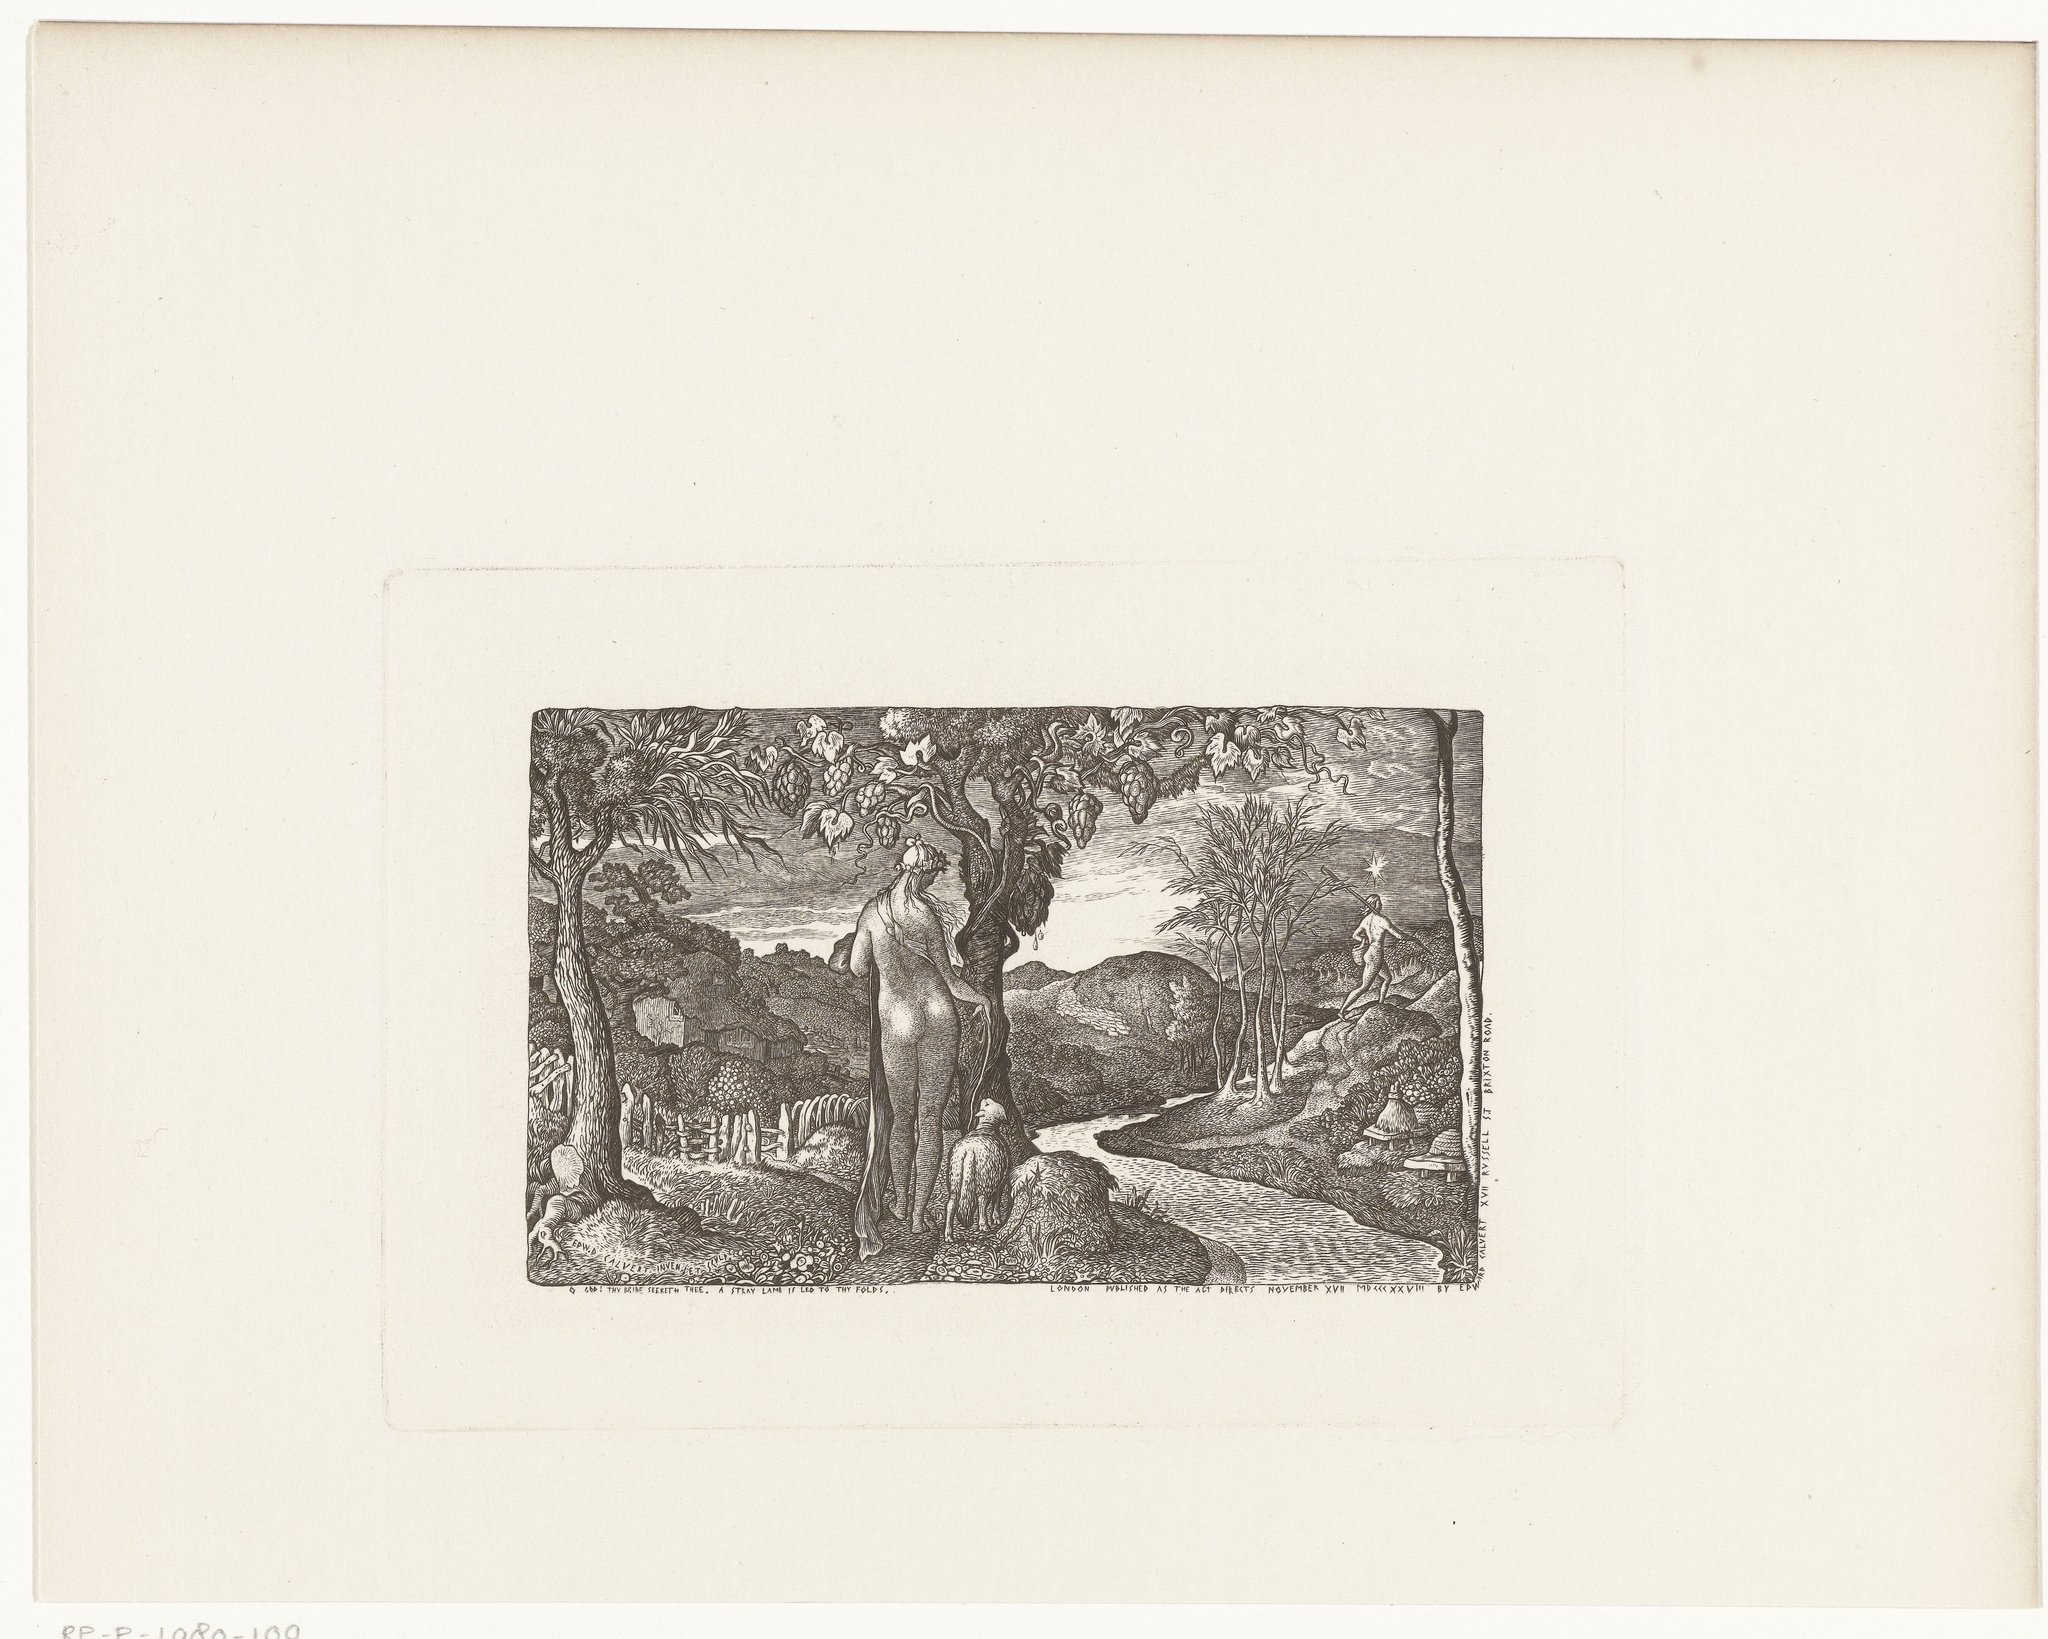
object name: print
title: De bruid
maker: edward calvert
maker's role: print maker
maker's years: 1799-1883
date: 1828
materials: paper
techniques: engraving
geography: england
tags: herding, herdsman, herdswoman, shepherd, shepherdess, cowherd, etc., brook, lamb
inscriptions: date: ‘17 november 1828’, collector's mark: Lugt 2760, collector's mark: Lugt 2228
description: Een naakte vrouw, van achteren gezien, lopend op een pad langs een rivier, naast haar een lam. Aan de overkant van de rivier een naakte man met een mand en herdersstaf. In de heuvels in de verte een herder met zijn kudde. Links onder de voorstelling de tekst: O God! Thy bride seeketh thee. A stray lamb is led to thy folds.